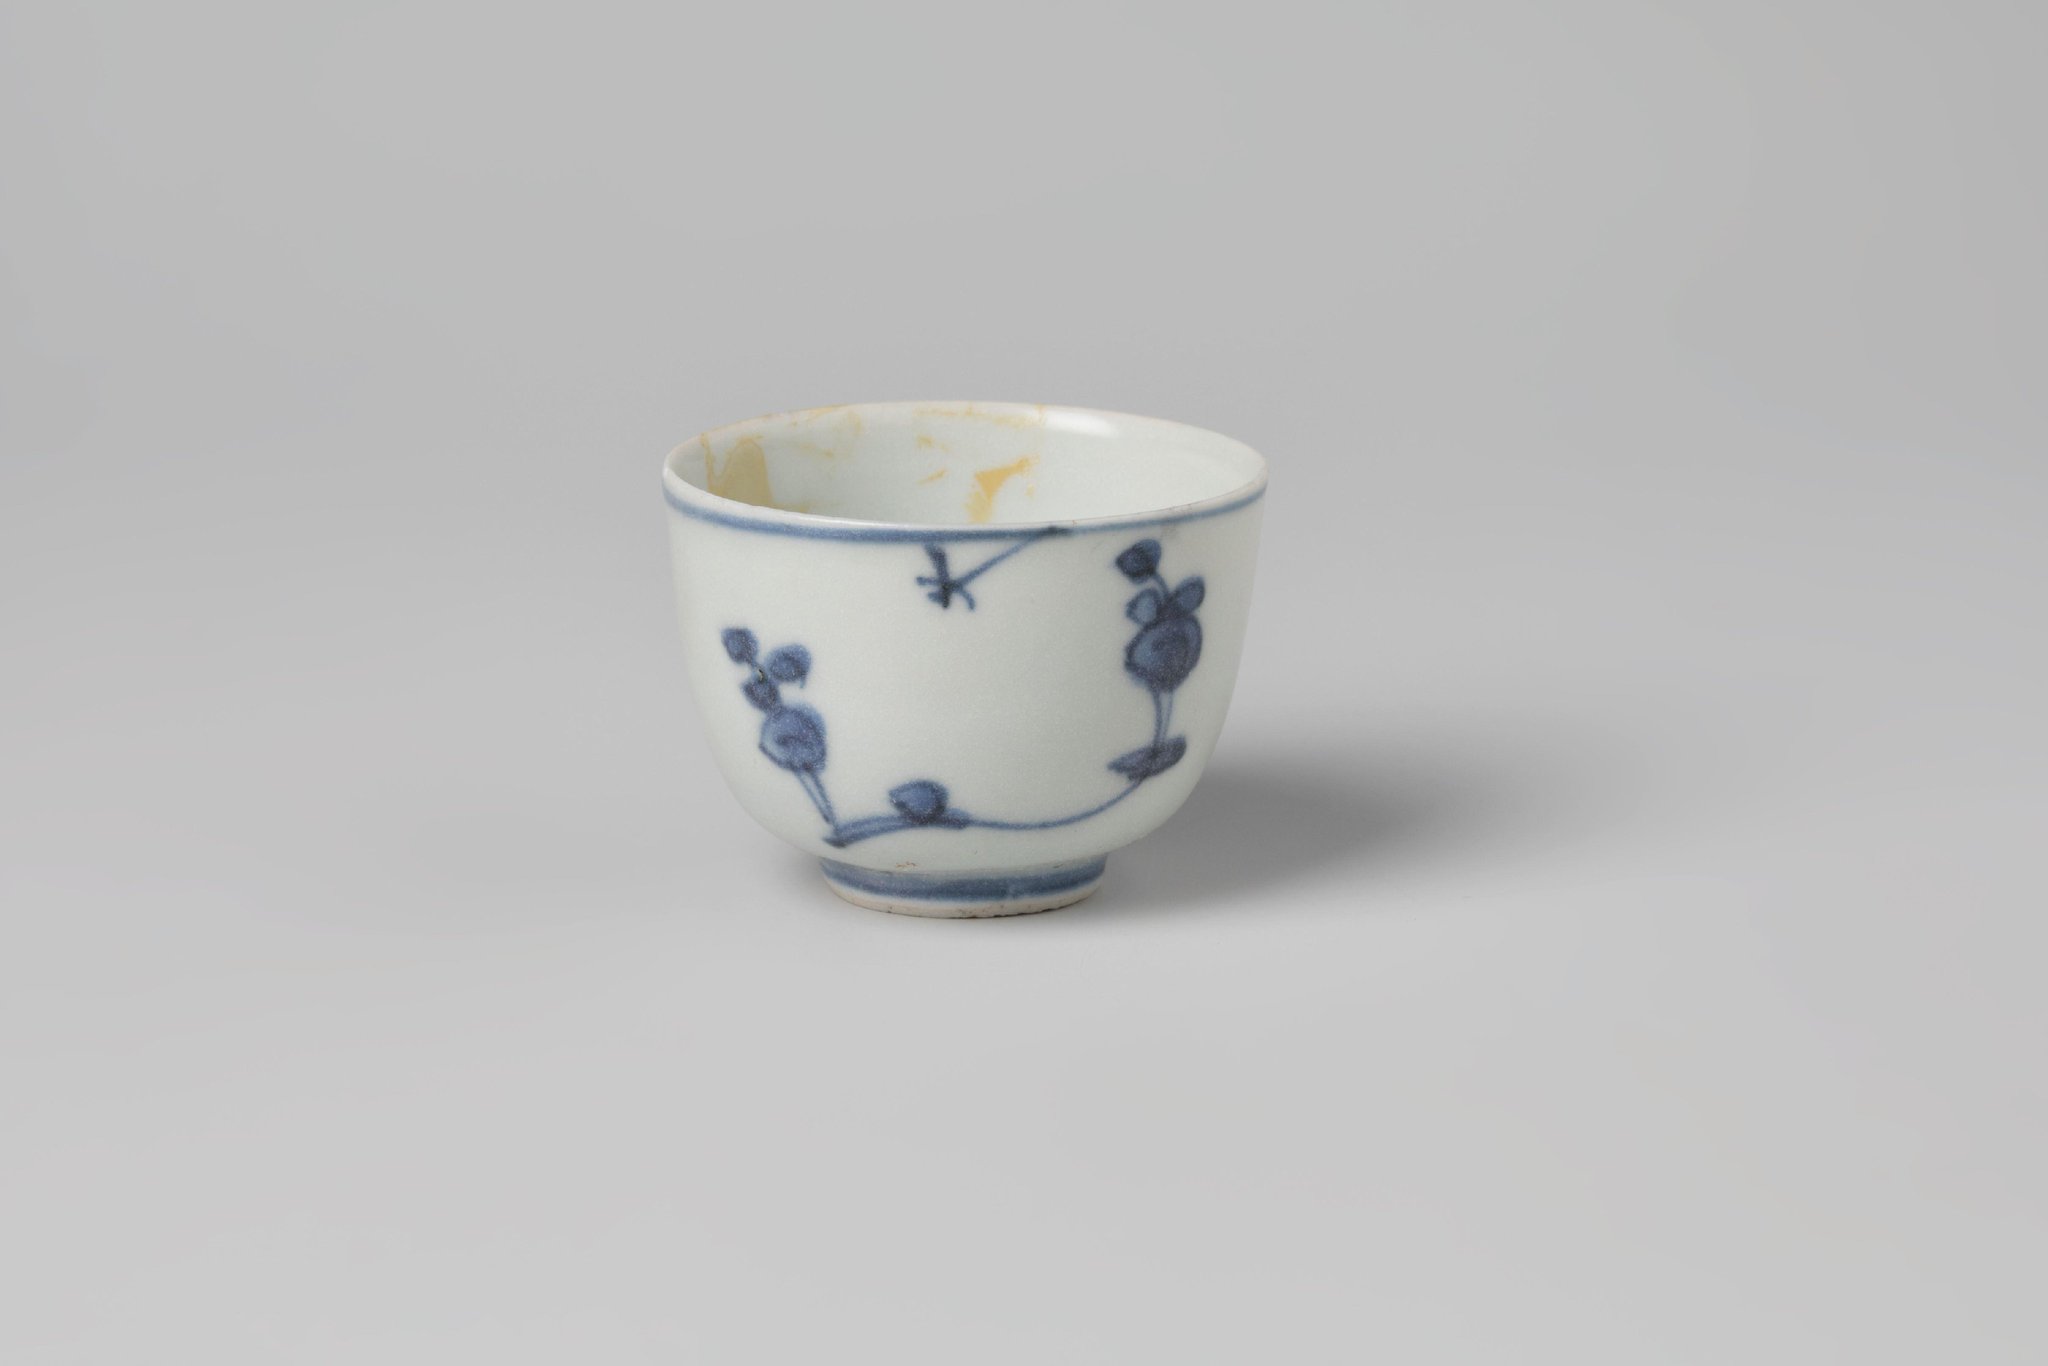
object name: wine cup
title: Wijnkom uit V.O.C.-schip de 'Witte Leeuw'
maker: Anonymous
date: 1613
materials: porcelain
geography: jingdezhen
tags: verenigde oostindische compagnie, sint-helena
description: A winecup. The inside is undecorated. On the outside two sketchy flowers on elongated stems with an insect drawn in between.